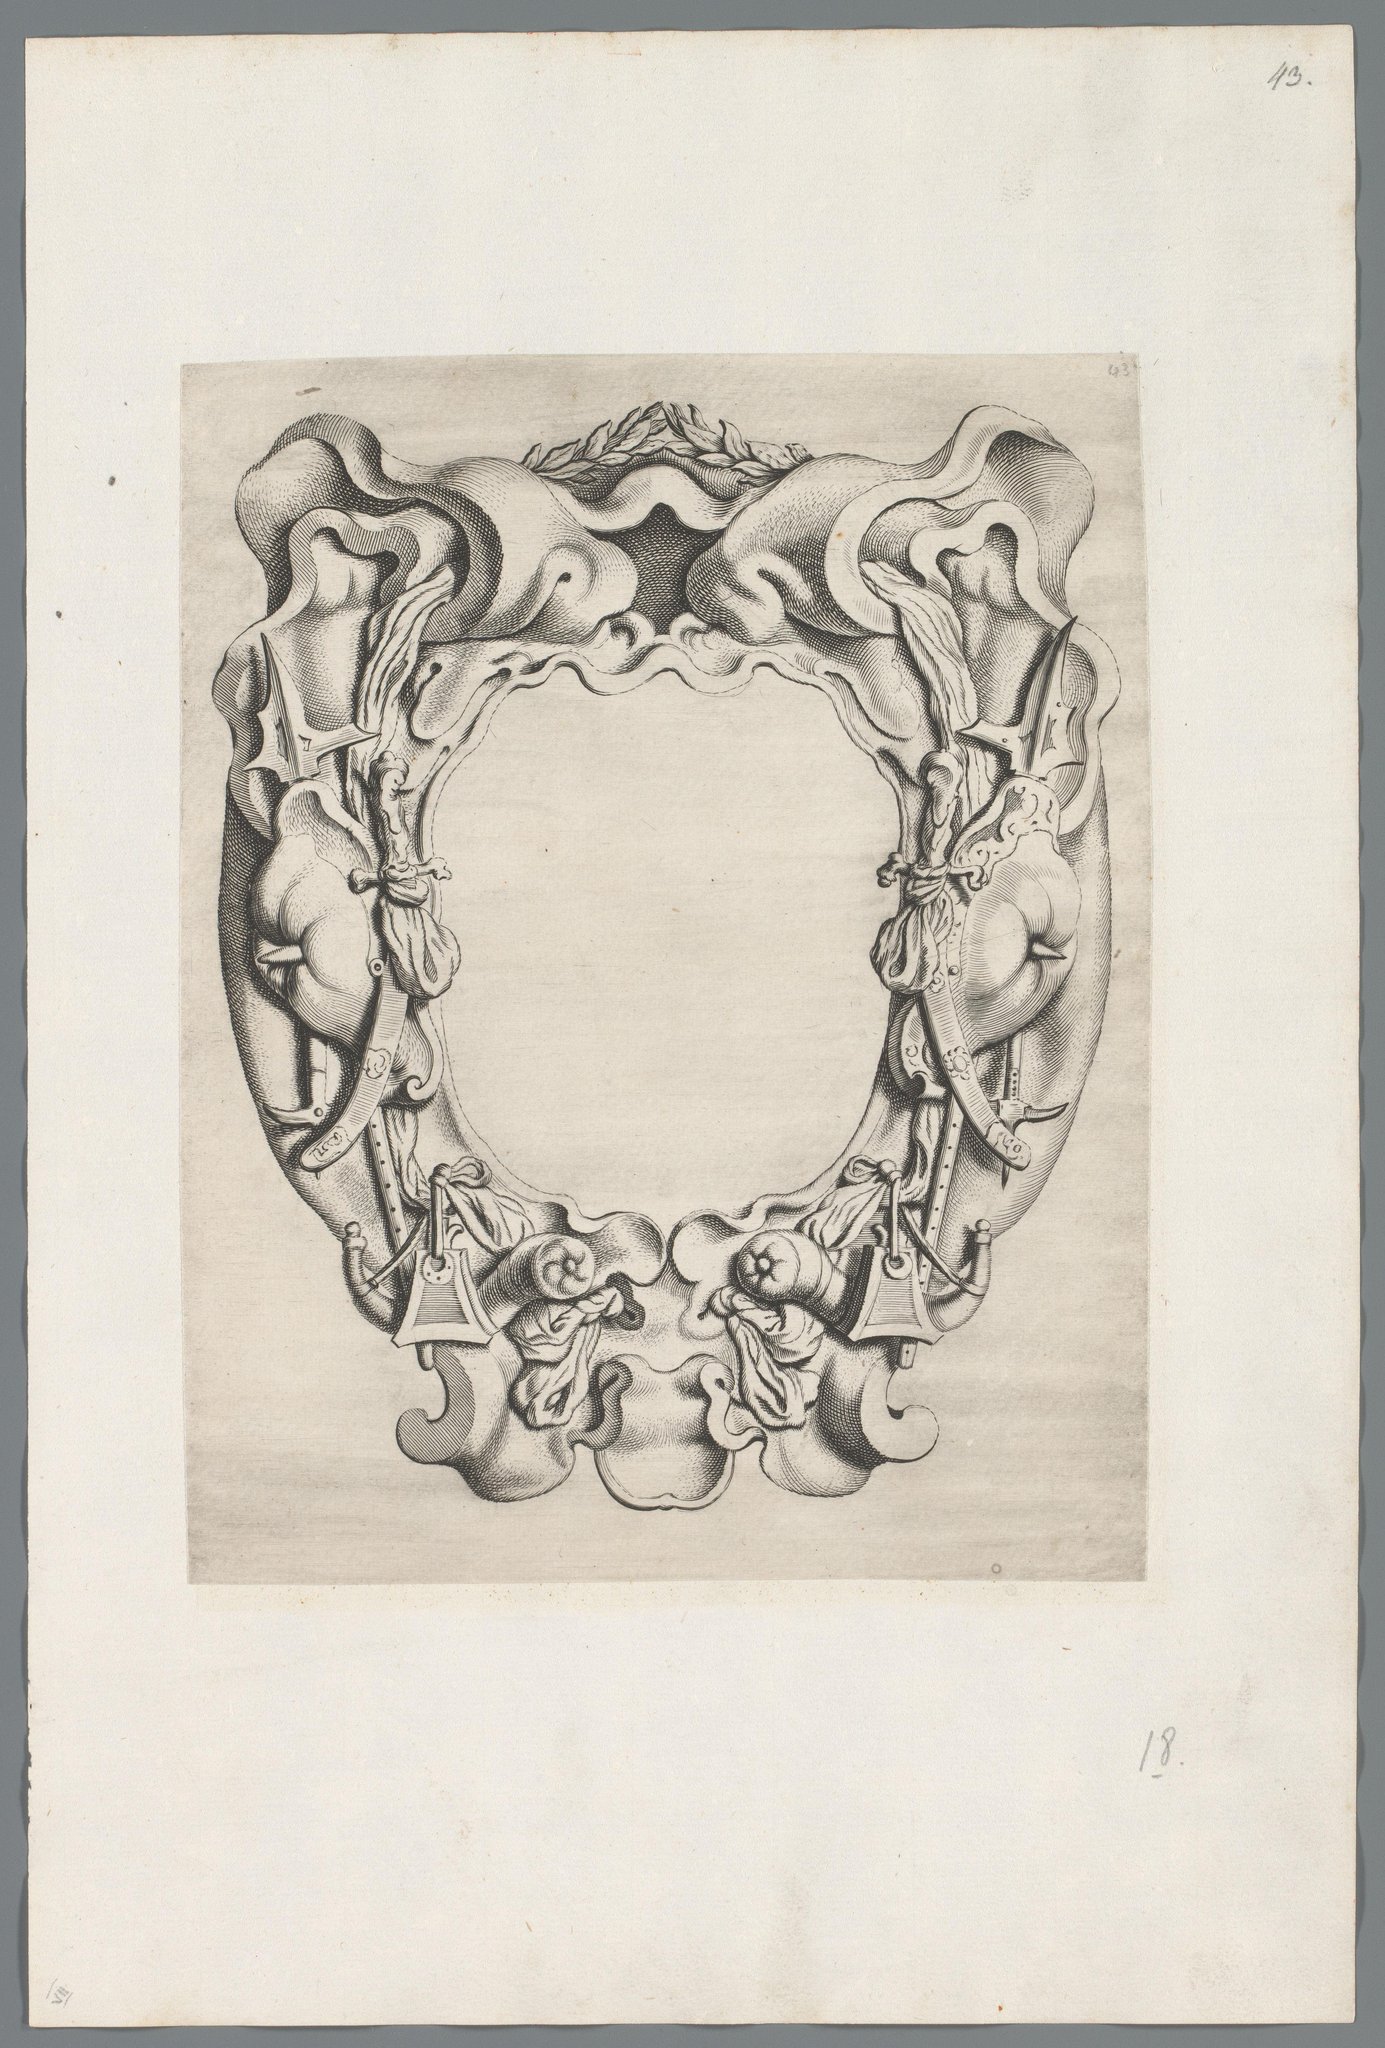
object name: ornament print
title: Diverse nieuwe cartouches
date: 1640-1674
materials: paper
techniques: engraving, etching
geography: amsterdam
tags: auricular ornament, lobe style ~ ornament, ornament ~ cartouche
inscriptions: collector's mark: Lugt 2228, collector's mark: Lugt 2760